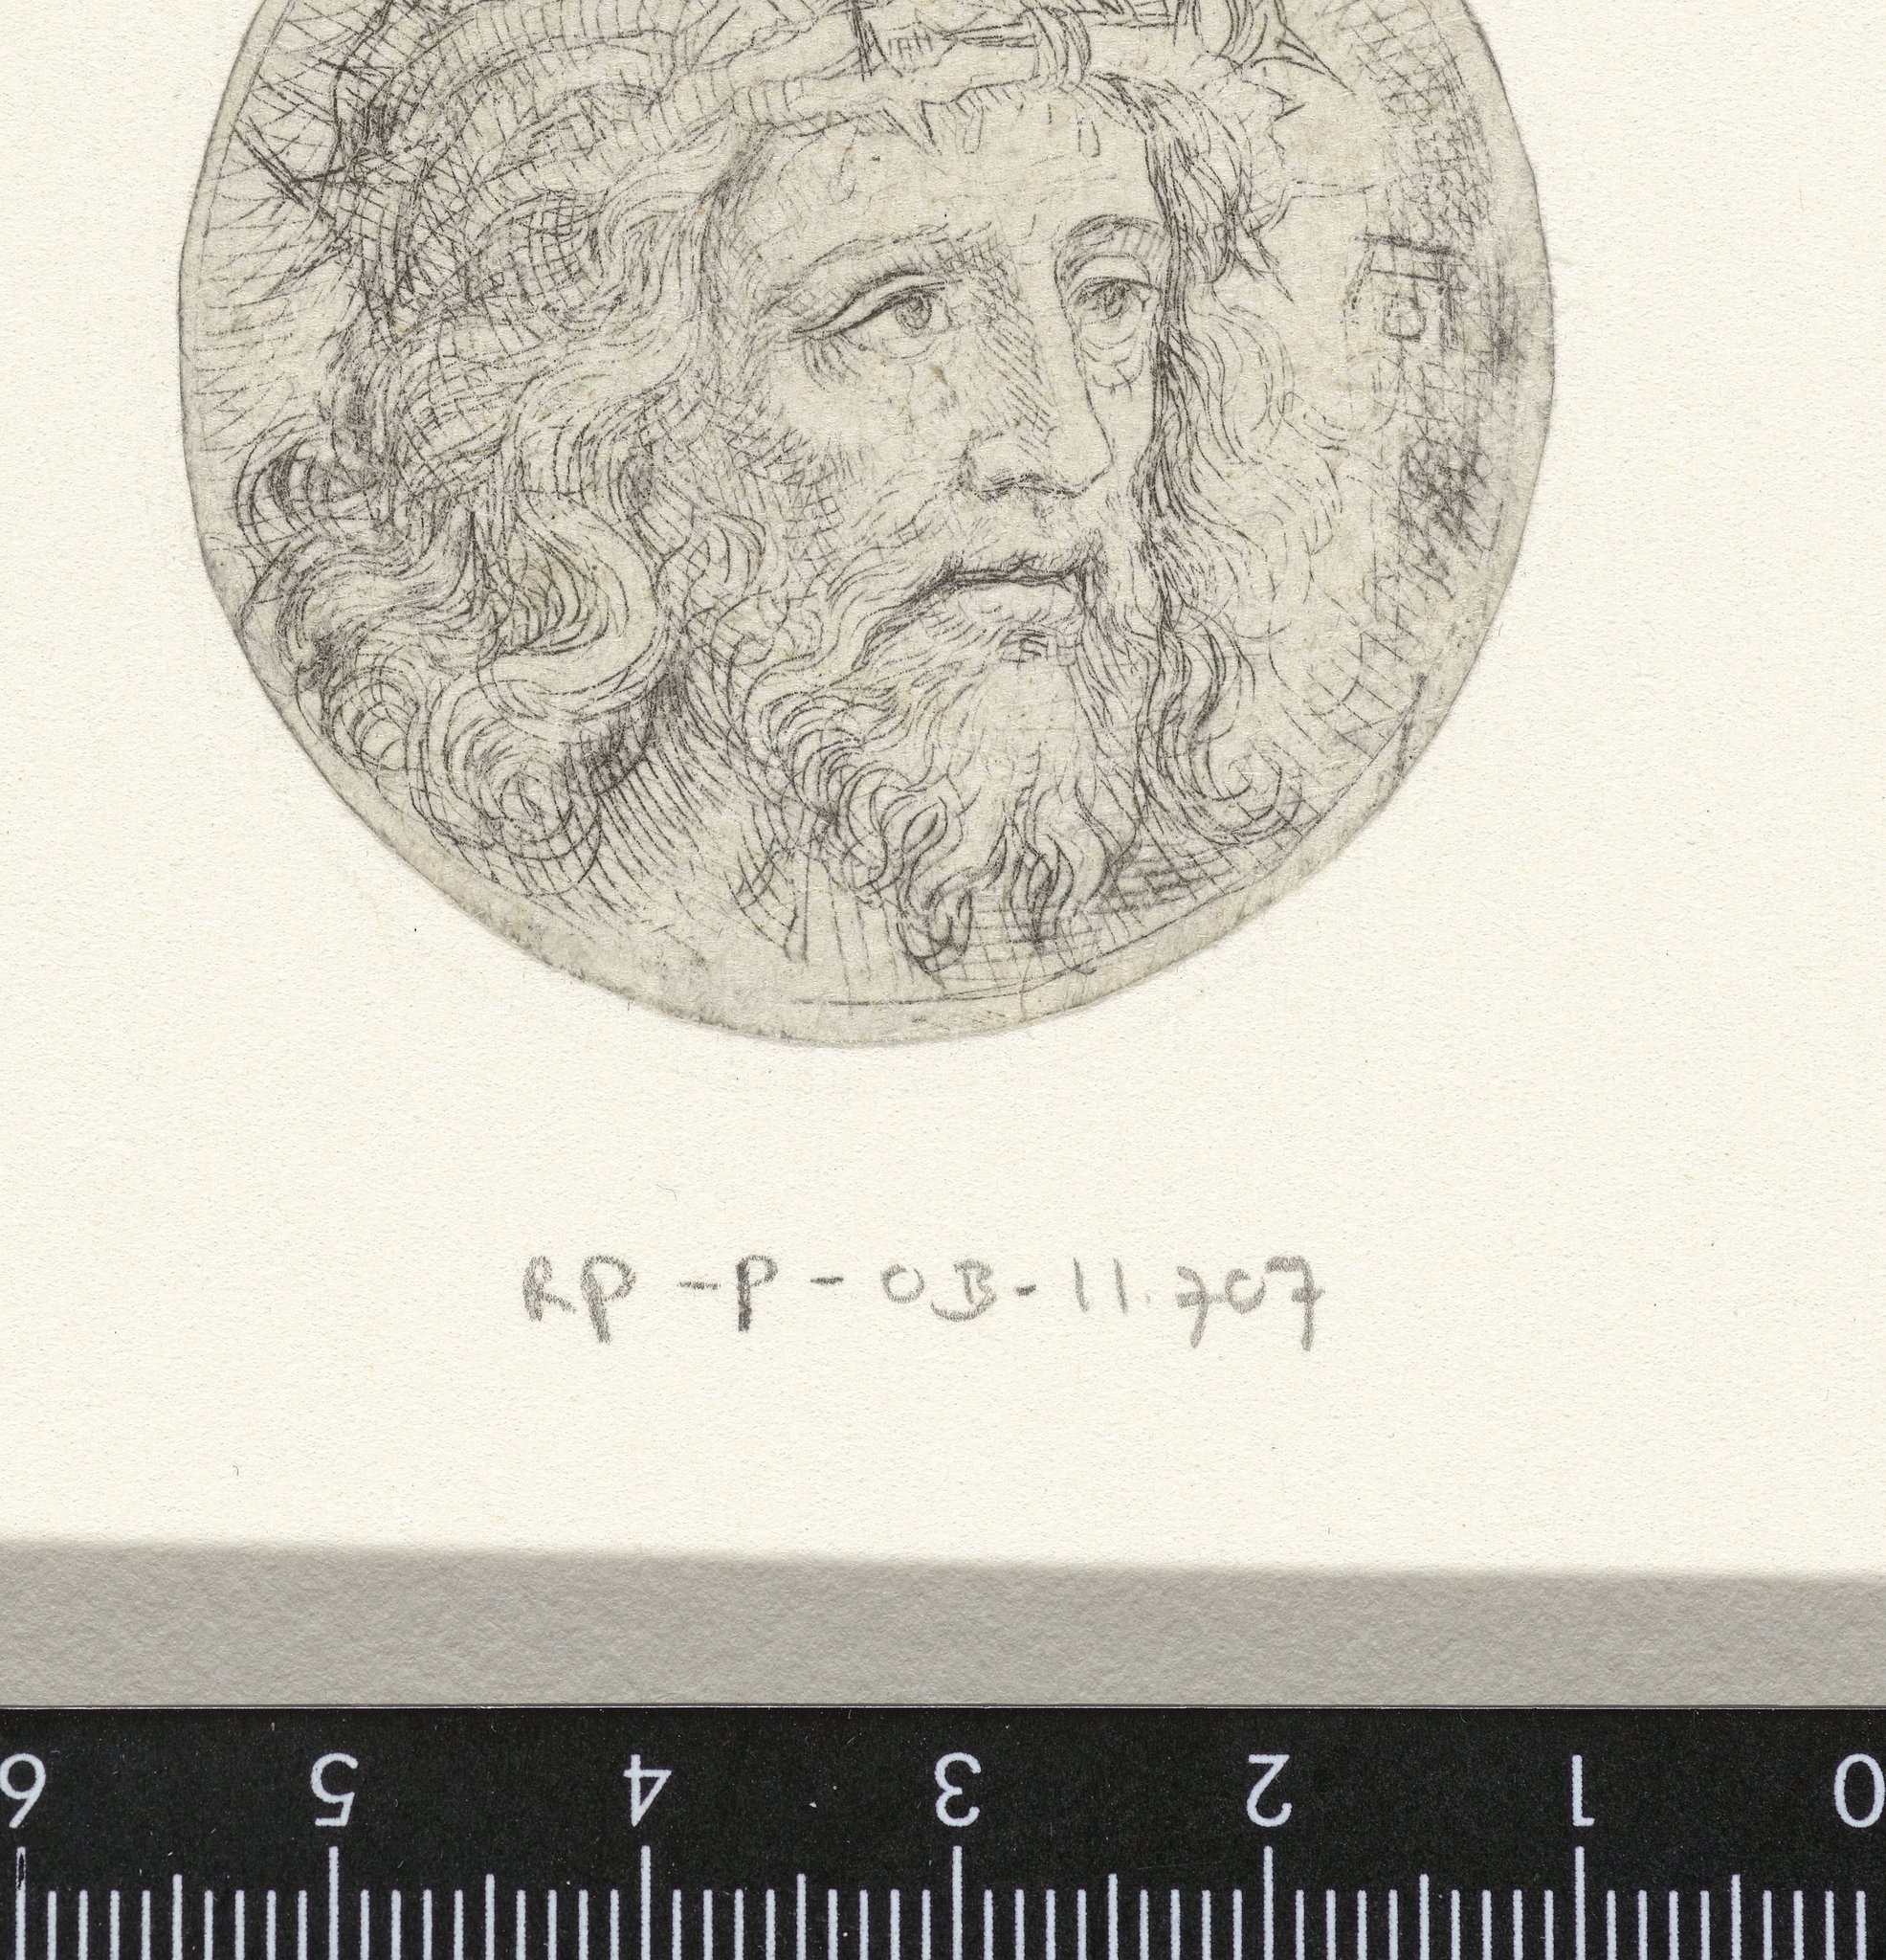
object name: print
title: Christus met de doornenkroon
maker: Anonymous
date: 1511-1513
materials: paper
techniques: drypoint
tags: head of christ with crown of thorns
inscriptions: collector's mark: Lugt 2228a, collector's mark: Lugt 2760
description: Ronde voorstelling van het hoofd van Christus met de doornenkroon op.